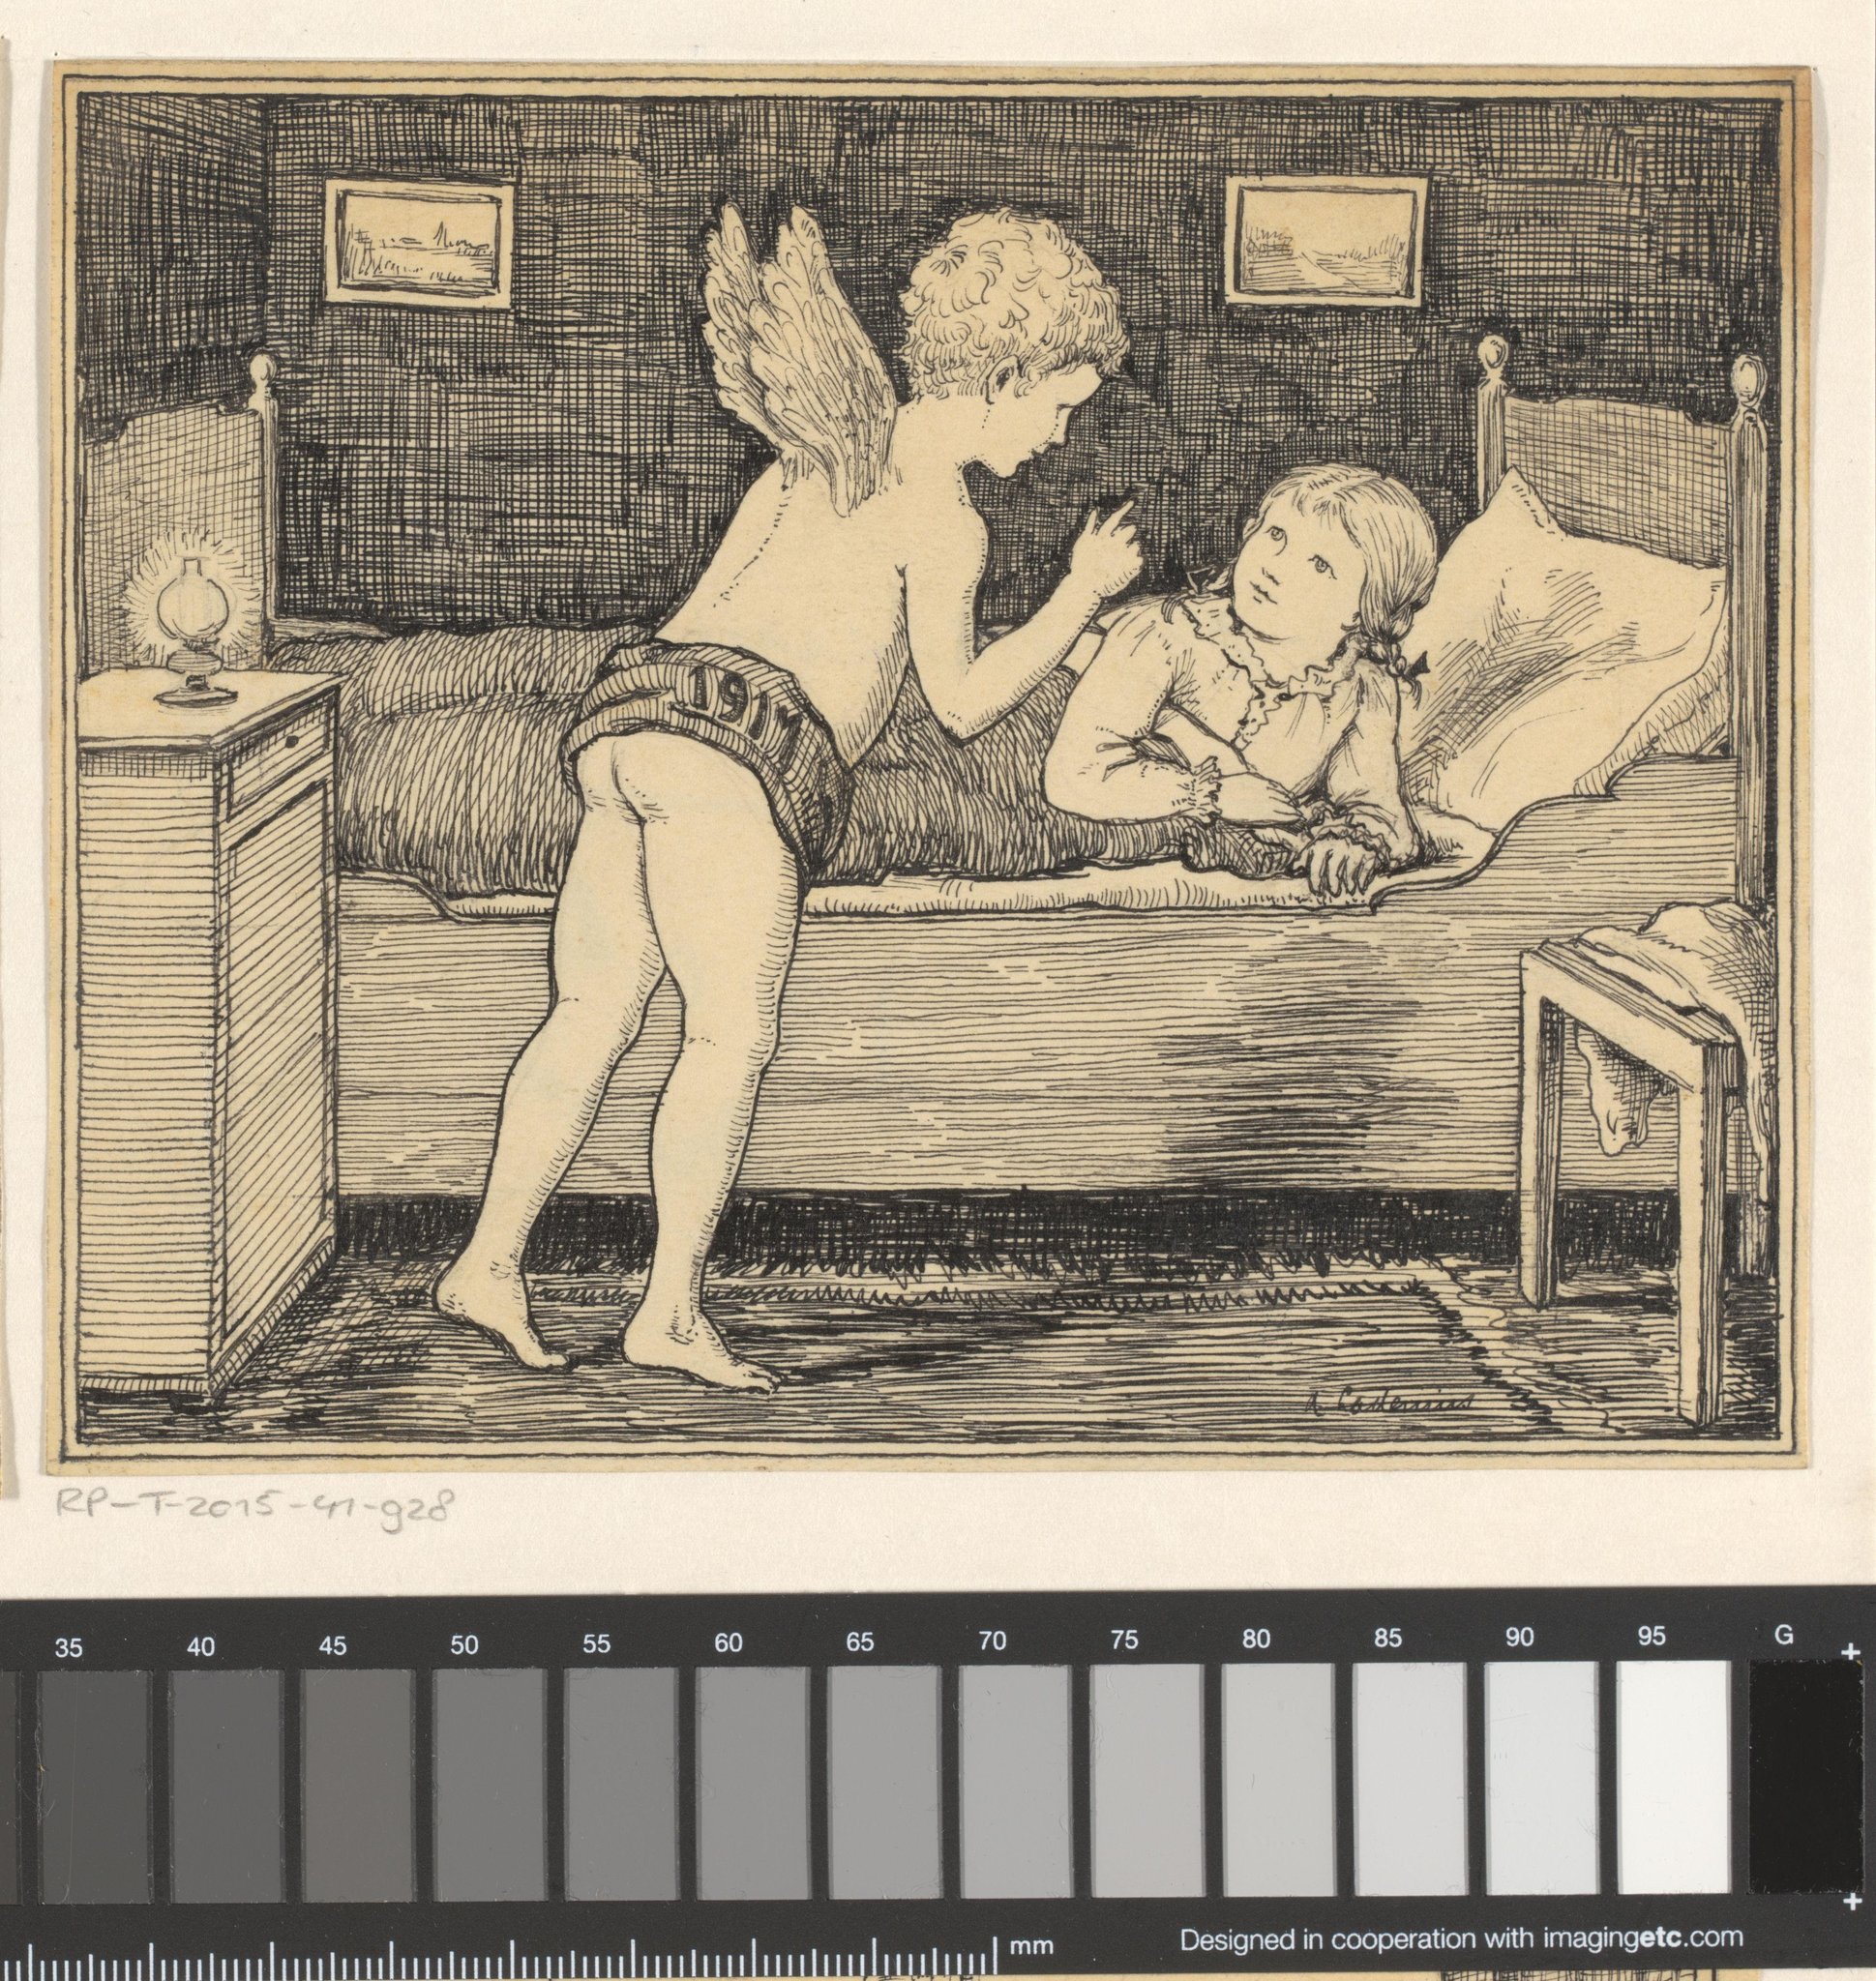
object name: drawing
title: Nieuwjaarsengel bezoekt Vera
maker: adri ladenius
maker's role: draughtsman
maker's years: 1883-1953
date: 1917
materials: ink, paper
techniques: pen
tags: bed, angels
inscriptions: signature: ‘A. Ladenius’, collector's mark: Lugt 2228, :, annotation: ‘Het nieuwjaarsengeltje’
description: De nieuwjaarsengel draagt een lendendoek met daarop '1917'. Hij staat aan het bed van Vera, die op haar ellebogen leunt en naar de engel kijkt.